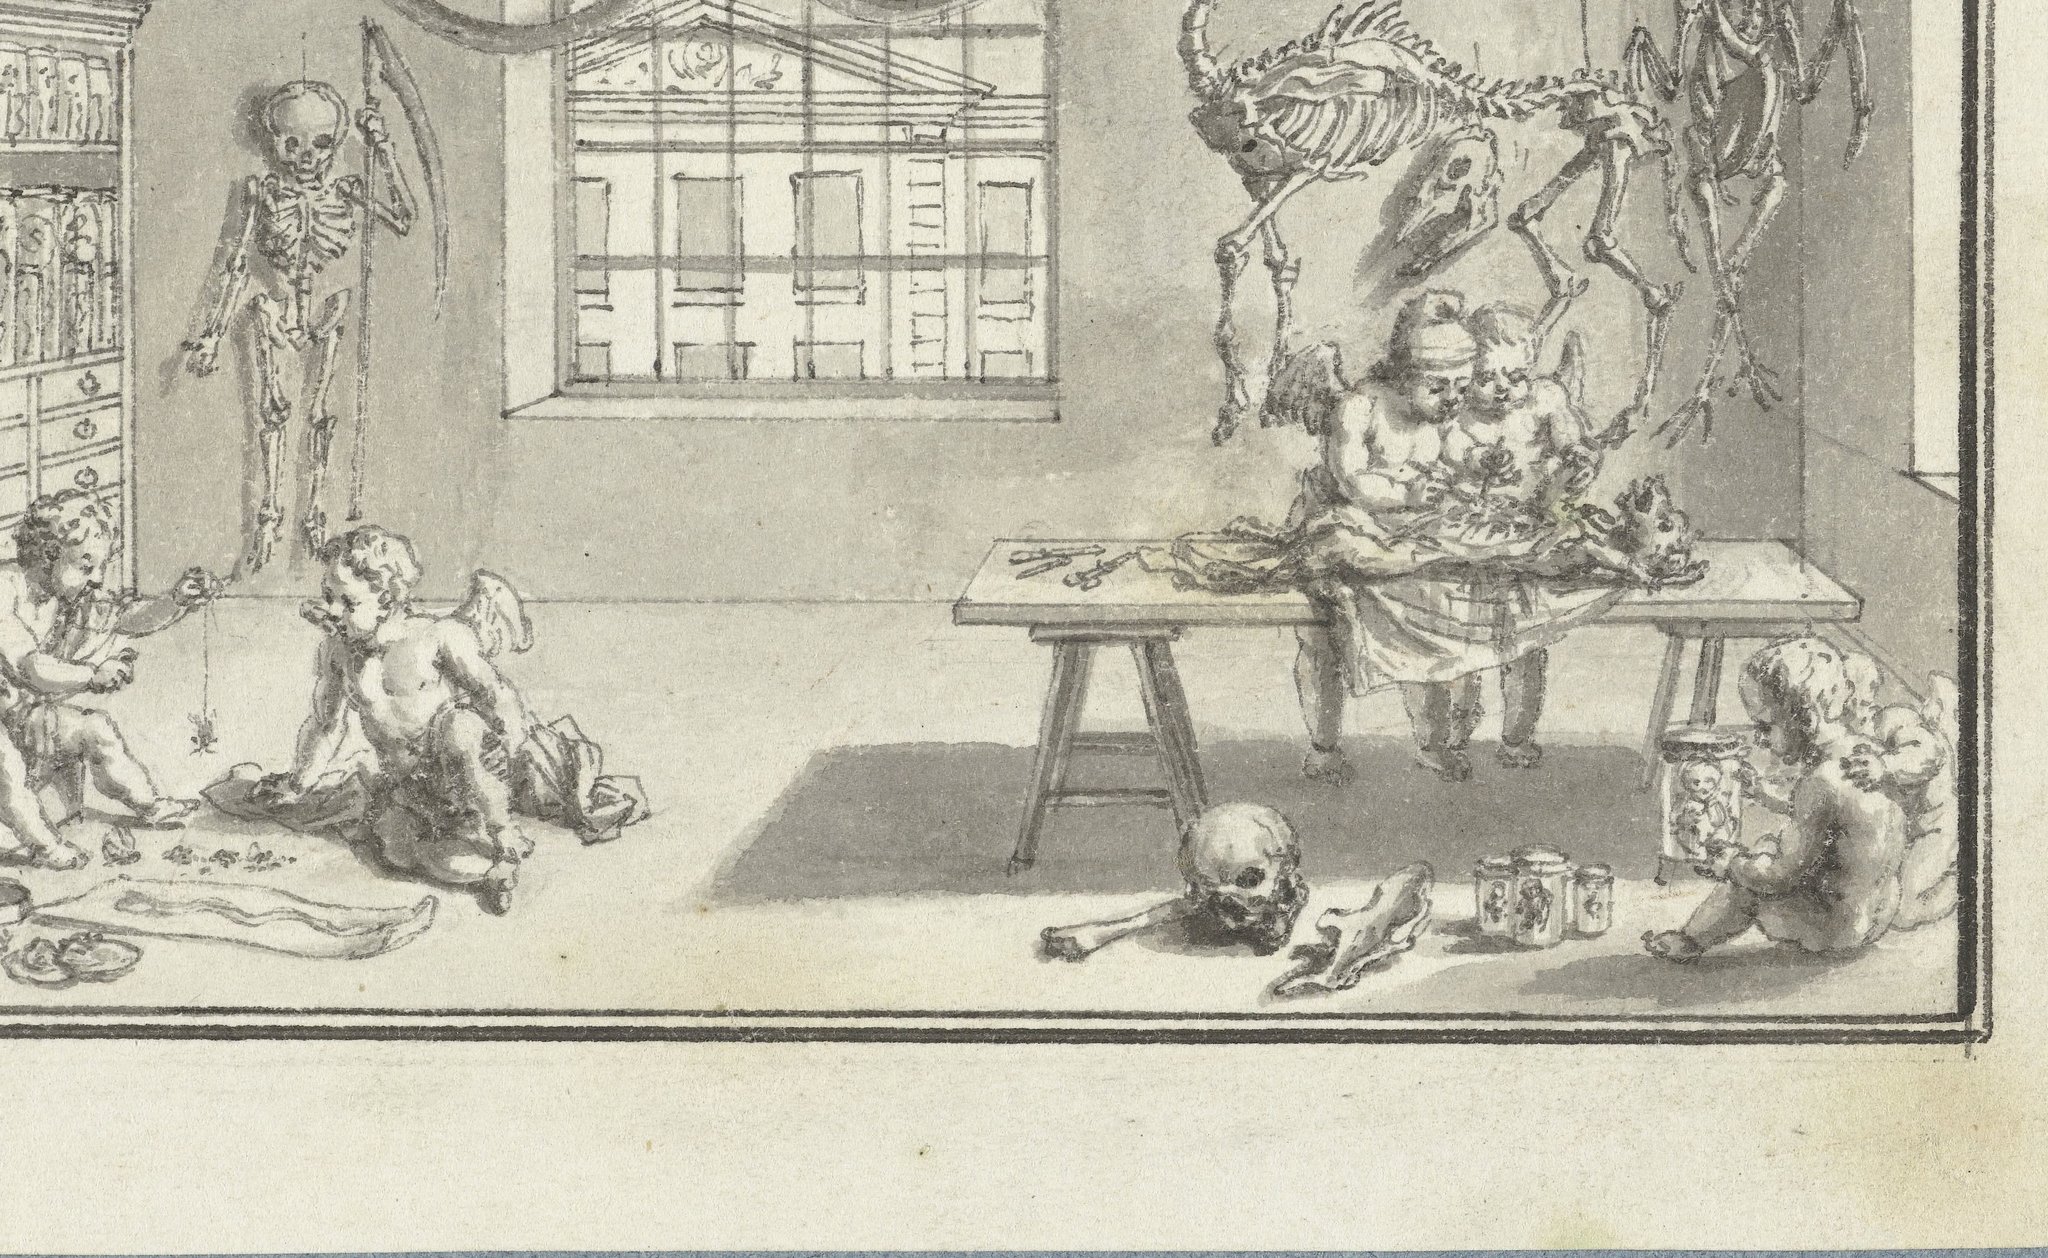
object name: drawing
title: Anatomie en Natuurgeschiedenis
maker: bernard picart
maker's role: draughtsman, print maker, publisher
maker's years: 1673-1733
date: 1683-1733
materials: ink, paper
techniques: brush, pen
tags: biology, dissection, laboratory